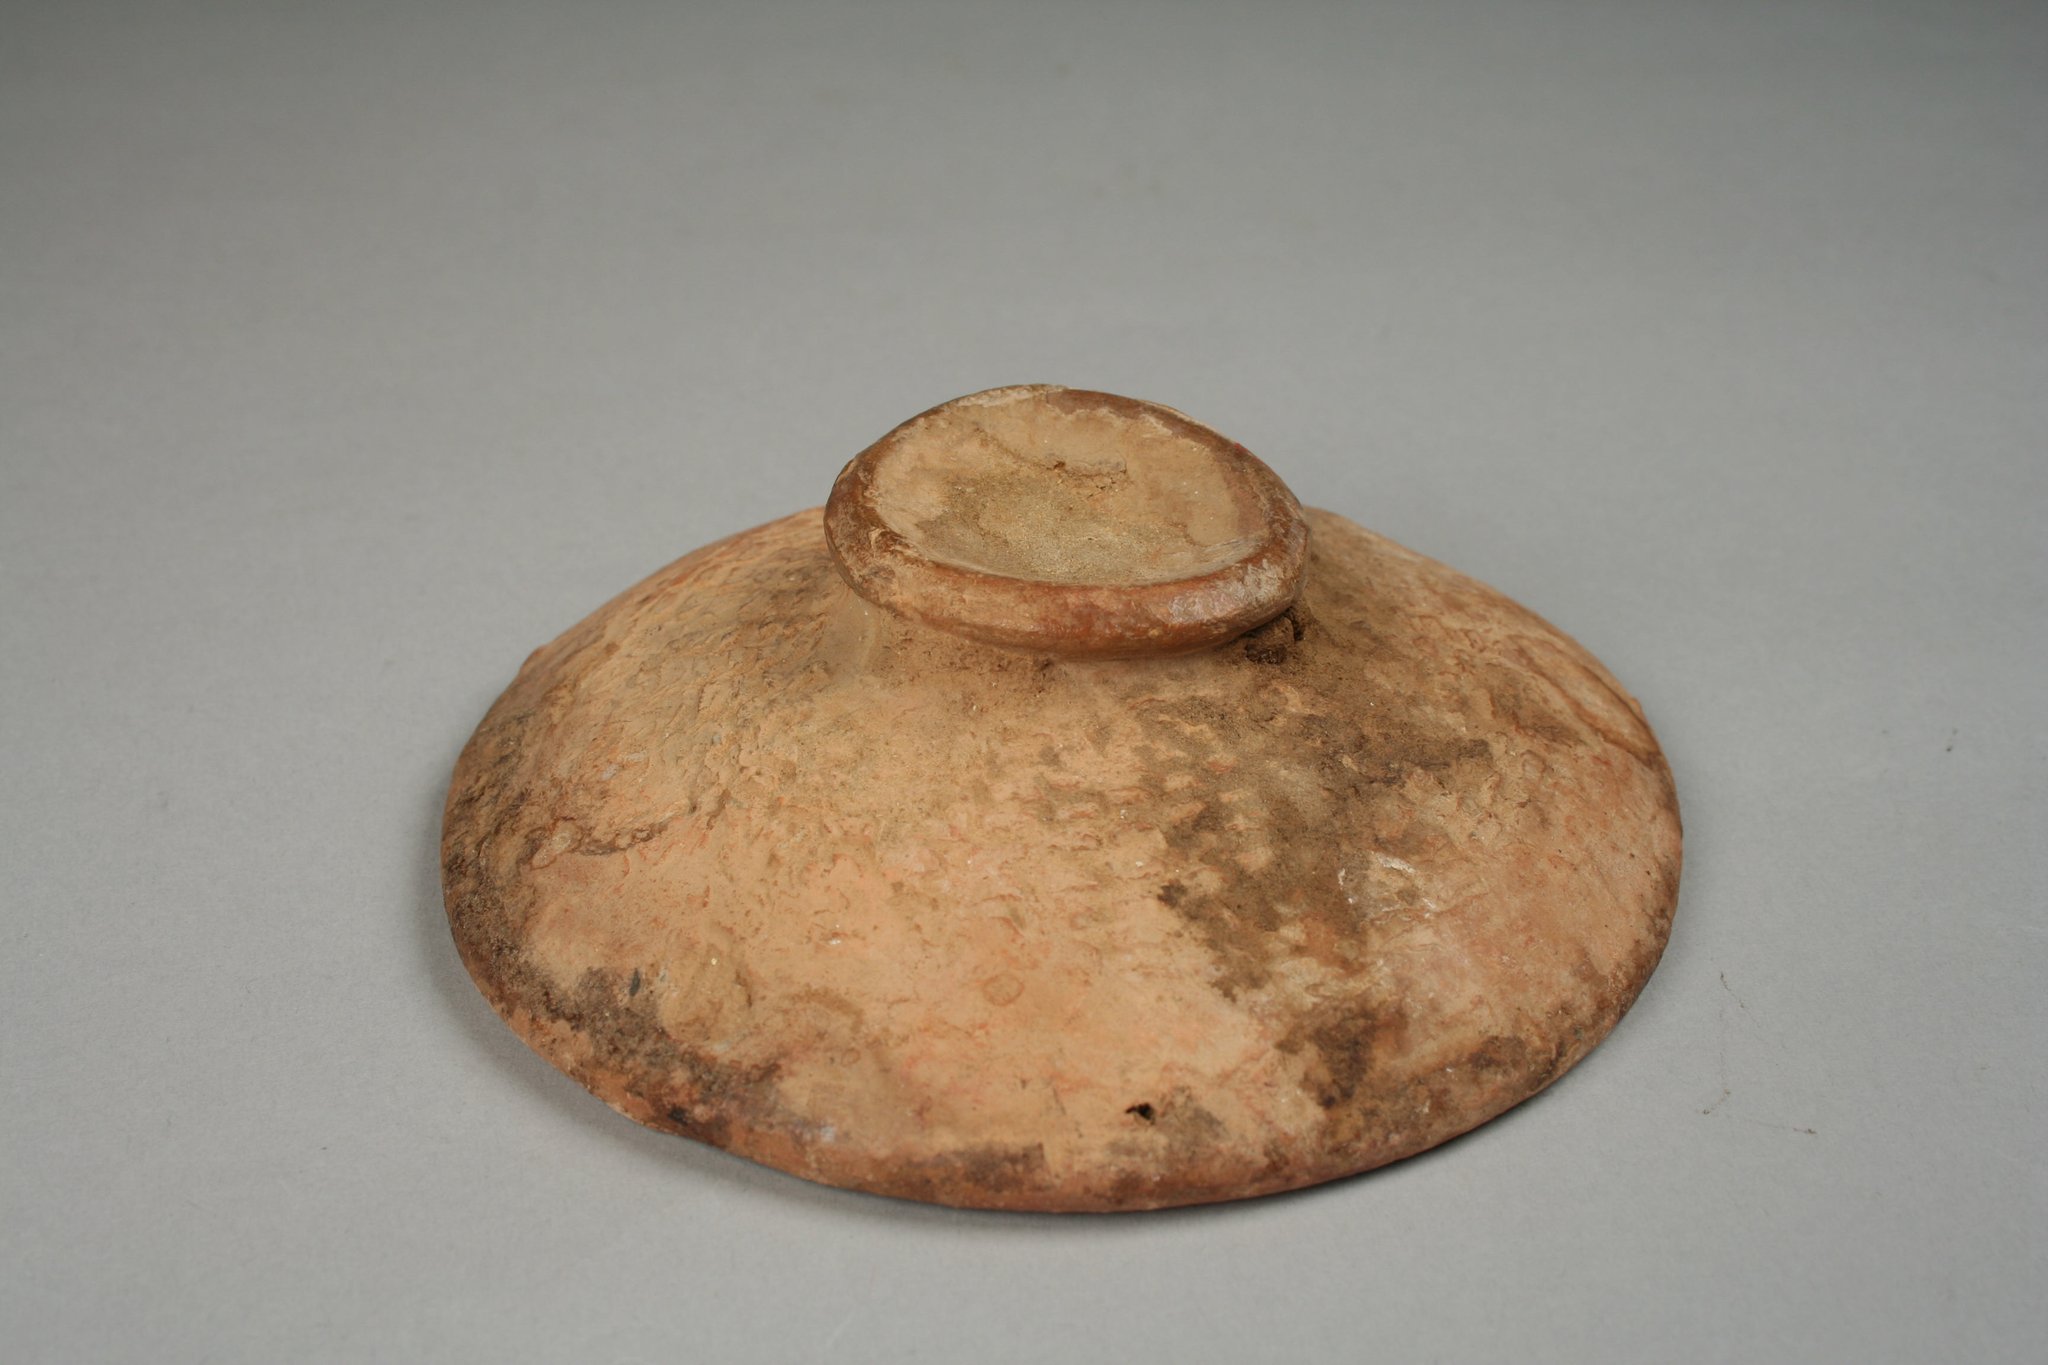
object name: lid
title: Vessel Lid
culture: dogon or tellem peoples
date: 1201-1300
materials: terracotta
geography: mali